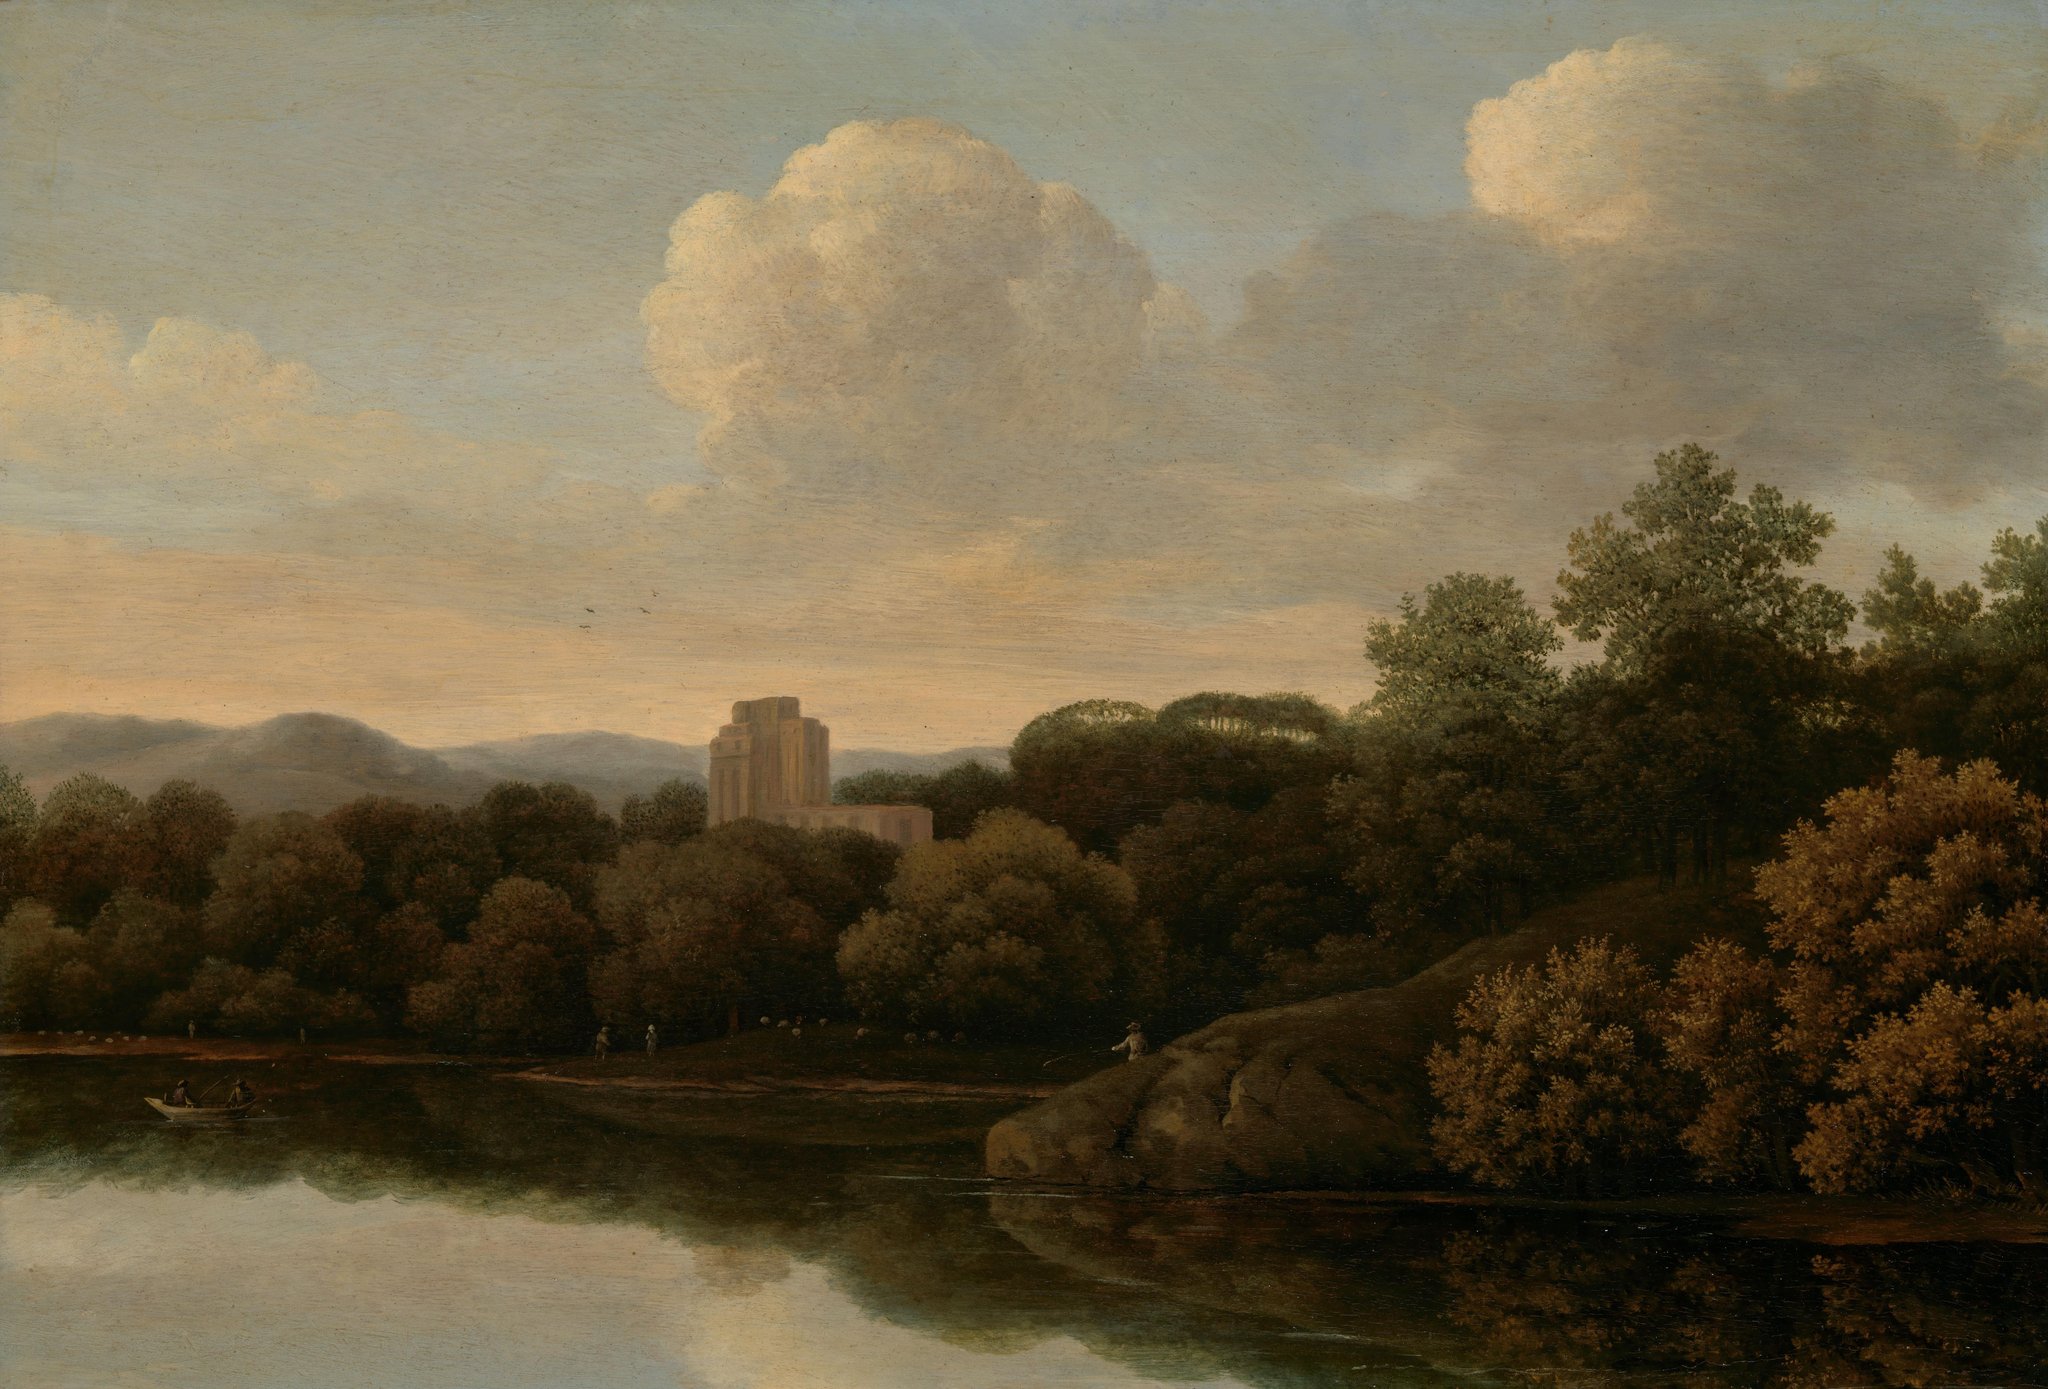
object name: painting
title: Wooded Landscape with River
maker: johan de lagoor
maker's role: draughtsman, painter, print maker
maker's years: 1620-1660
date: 1645-1680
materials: oil, panel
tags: river, landscape with ruins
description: Boslandschap met rivier op de voorgrond. Aan de oever rechts staat een hengelaar, verderop herders met schapen. Tussen de bomen de ruïne van een kasteel.